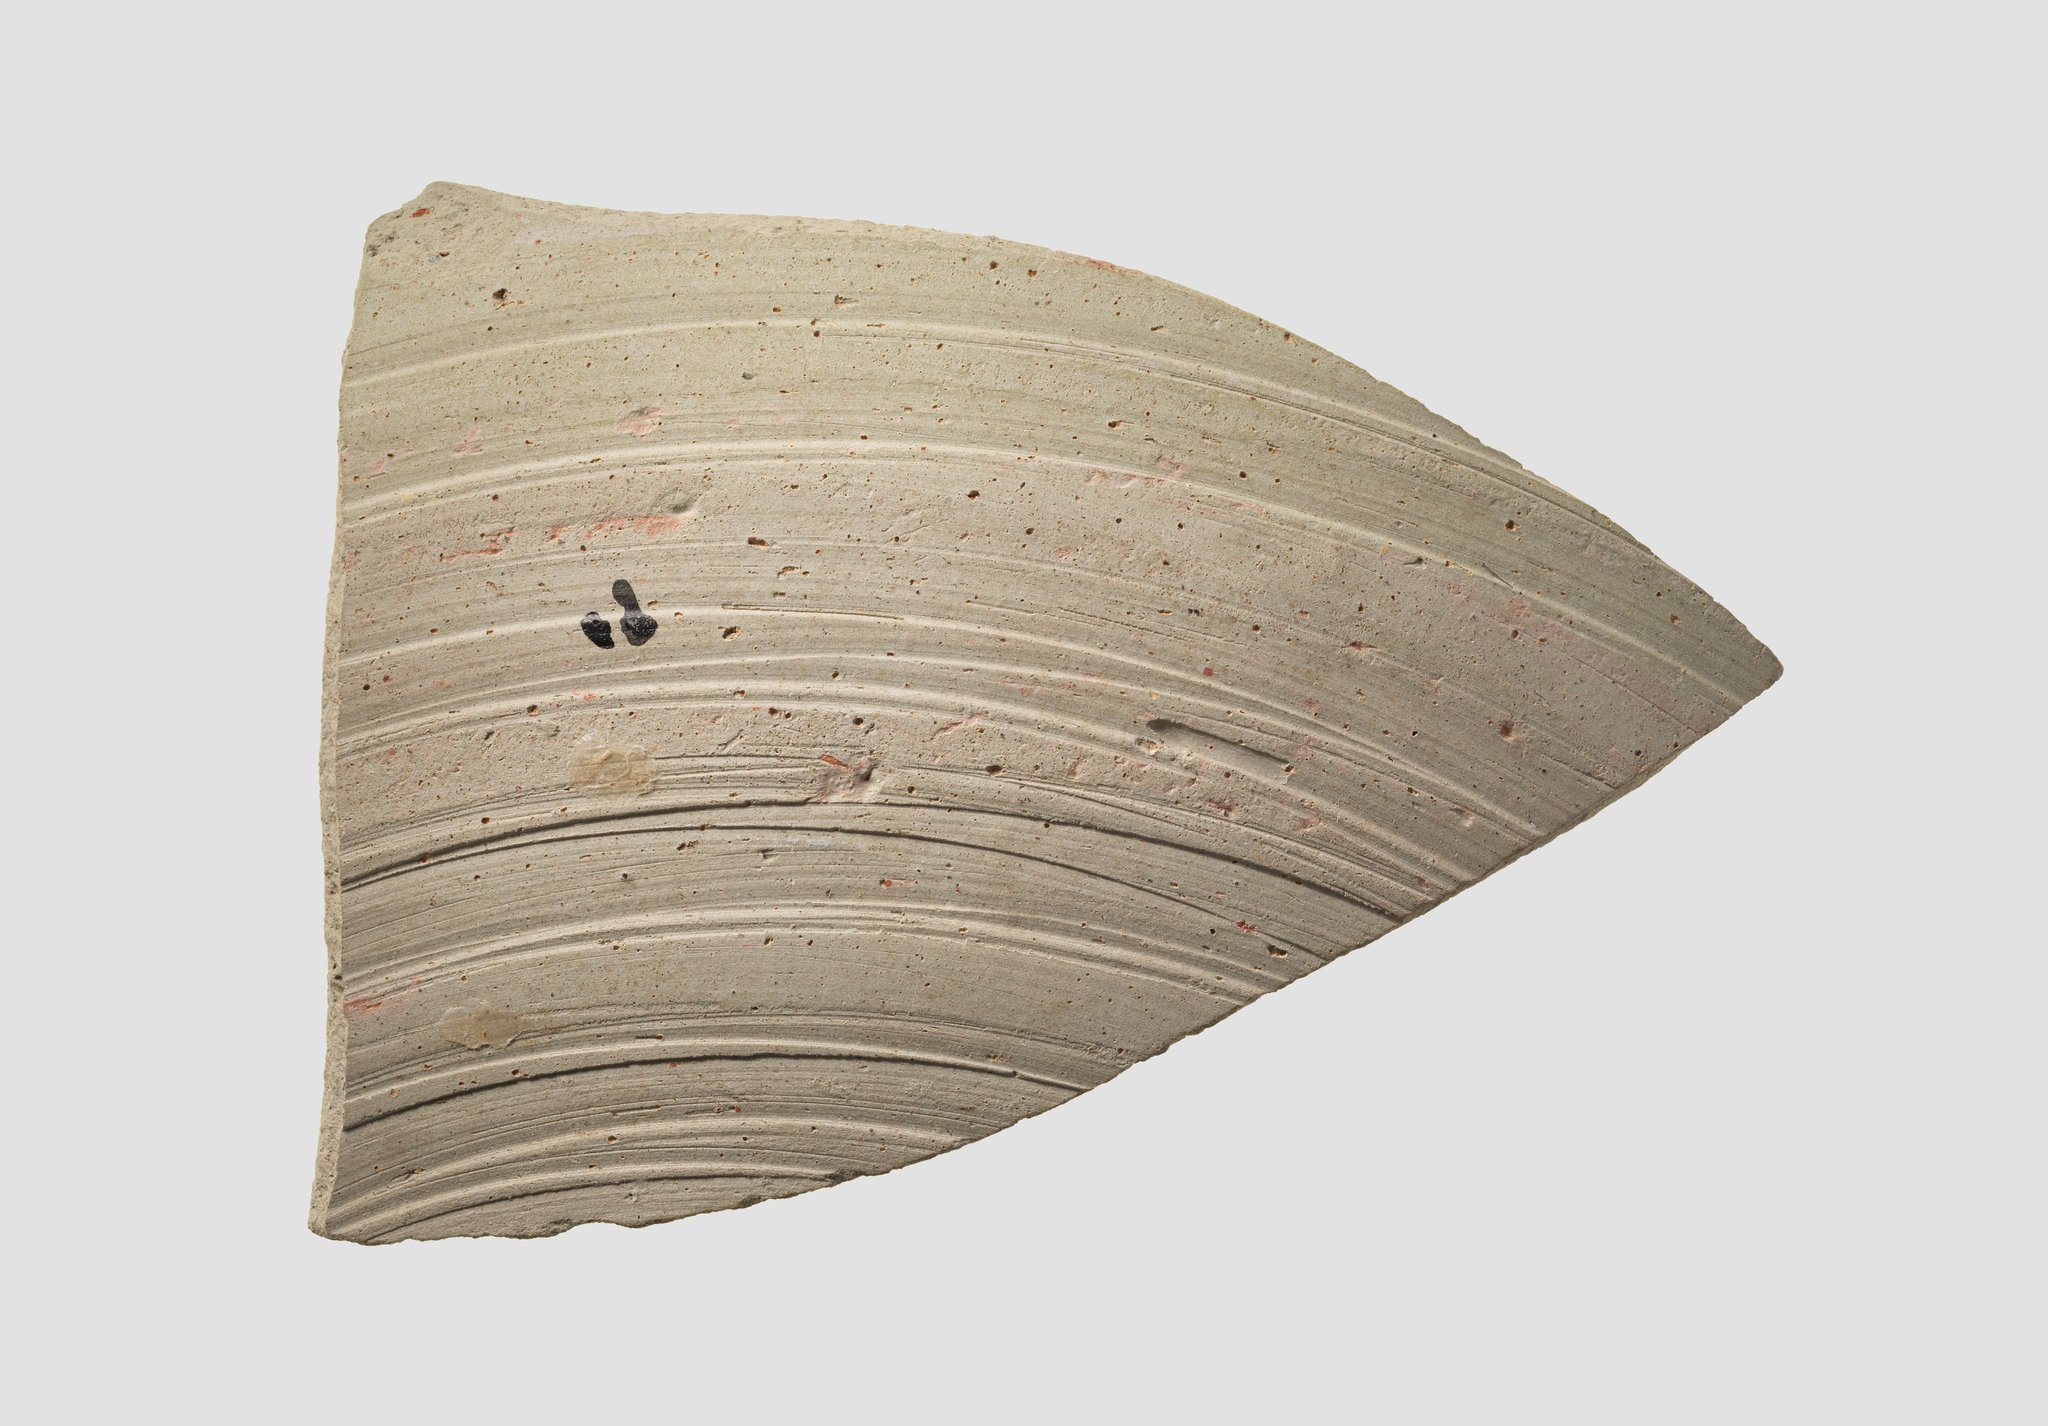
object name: bowl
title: Bowl sherd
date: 2333-2001 BCE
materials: ceramic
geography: mesopotamia